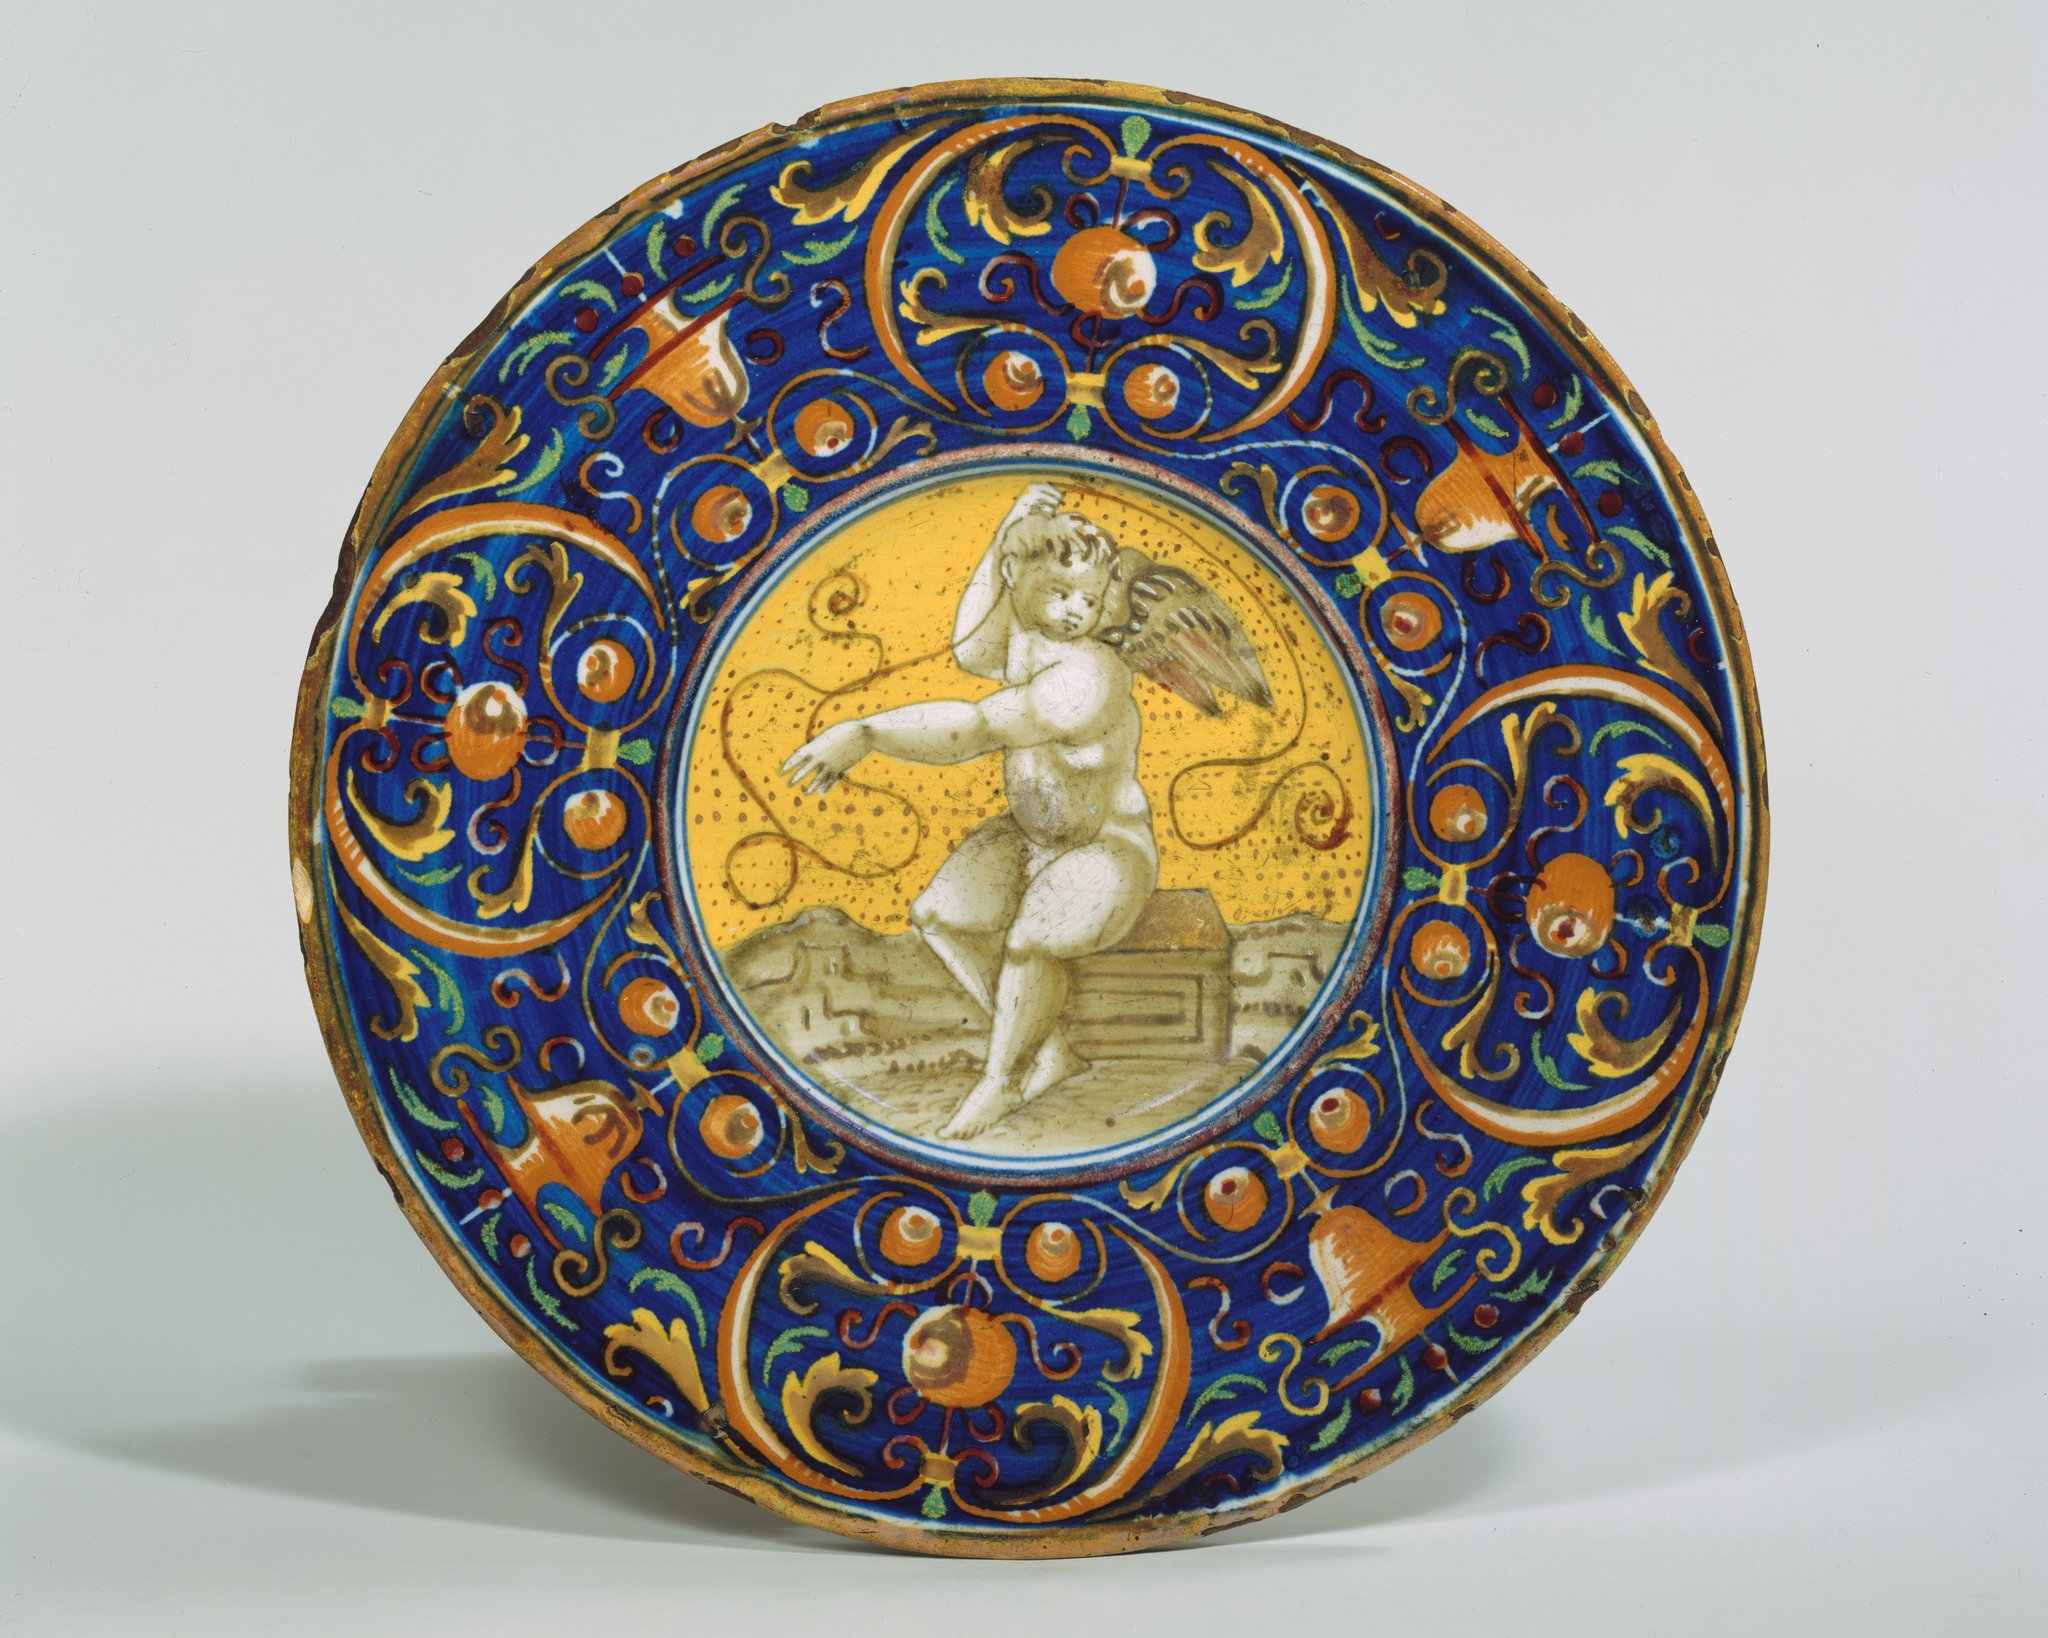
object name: plate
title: Plate (tagliere)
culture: italian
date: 1534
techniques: maiolica, glazing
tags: putti